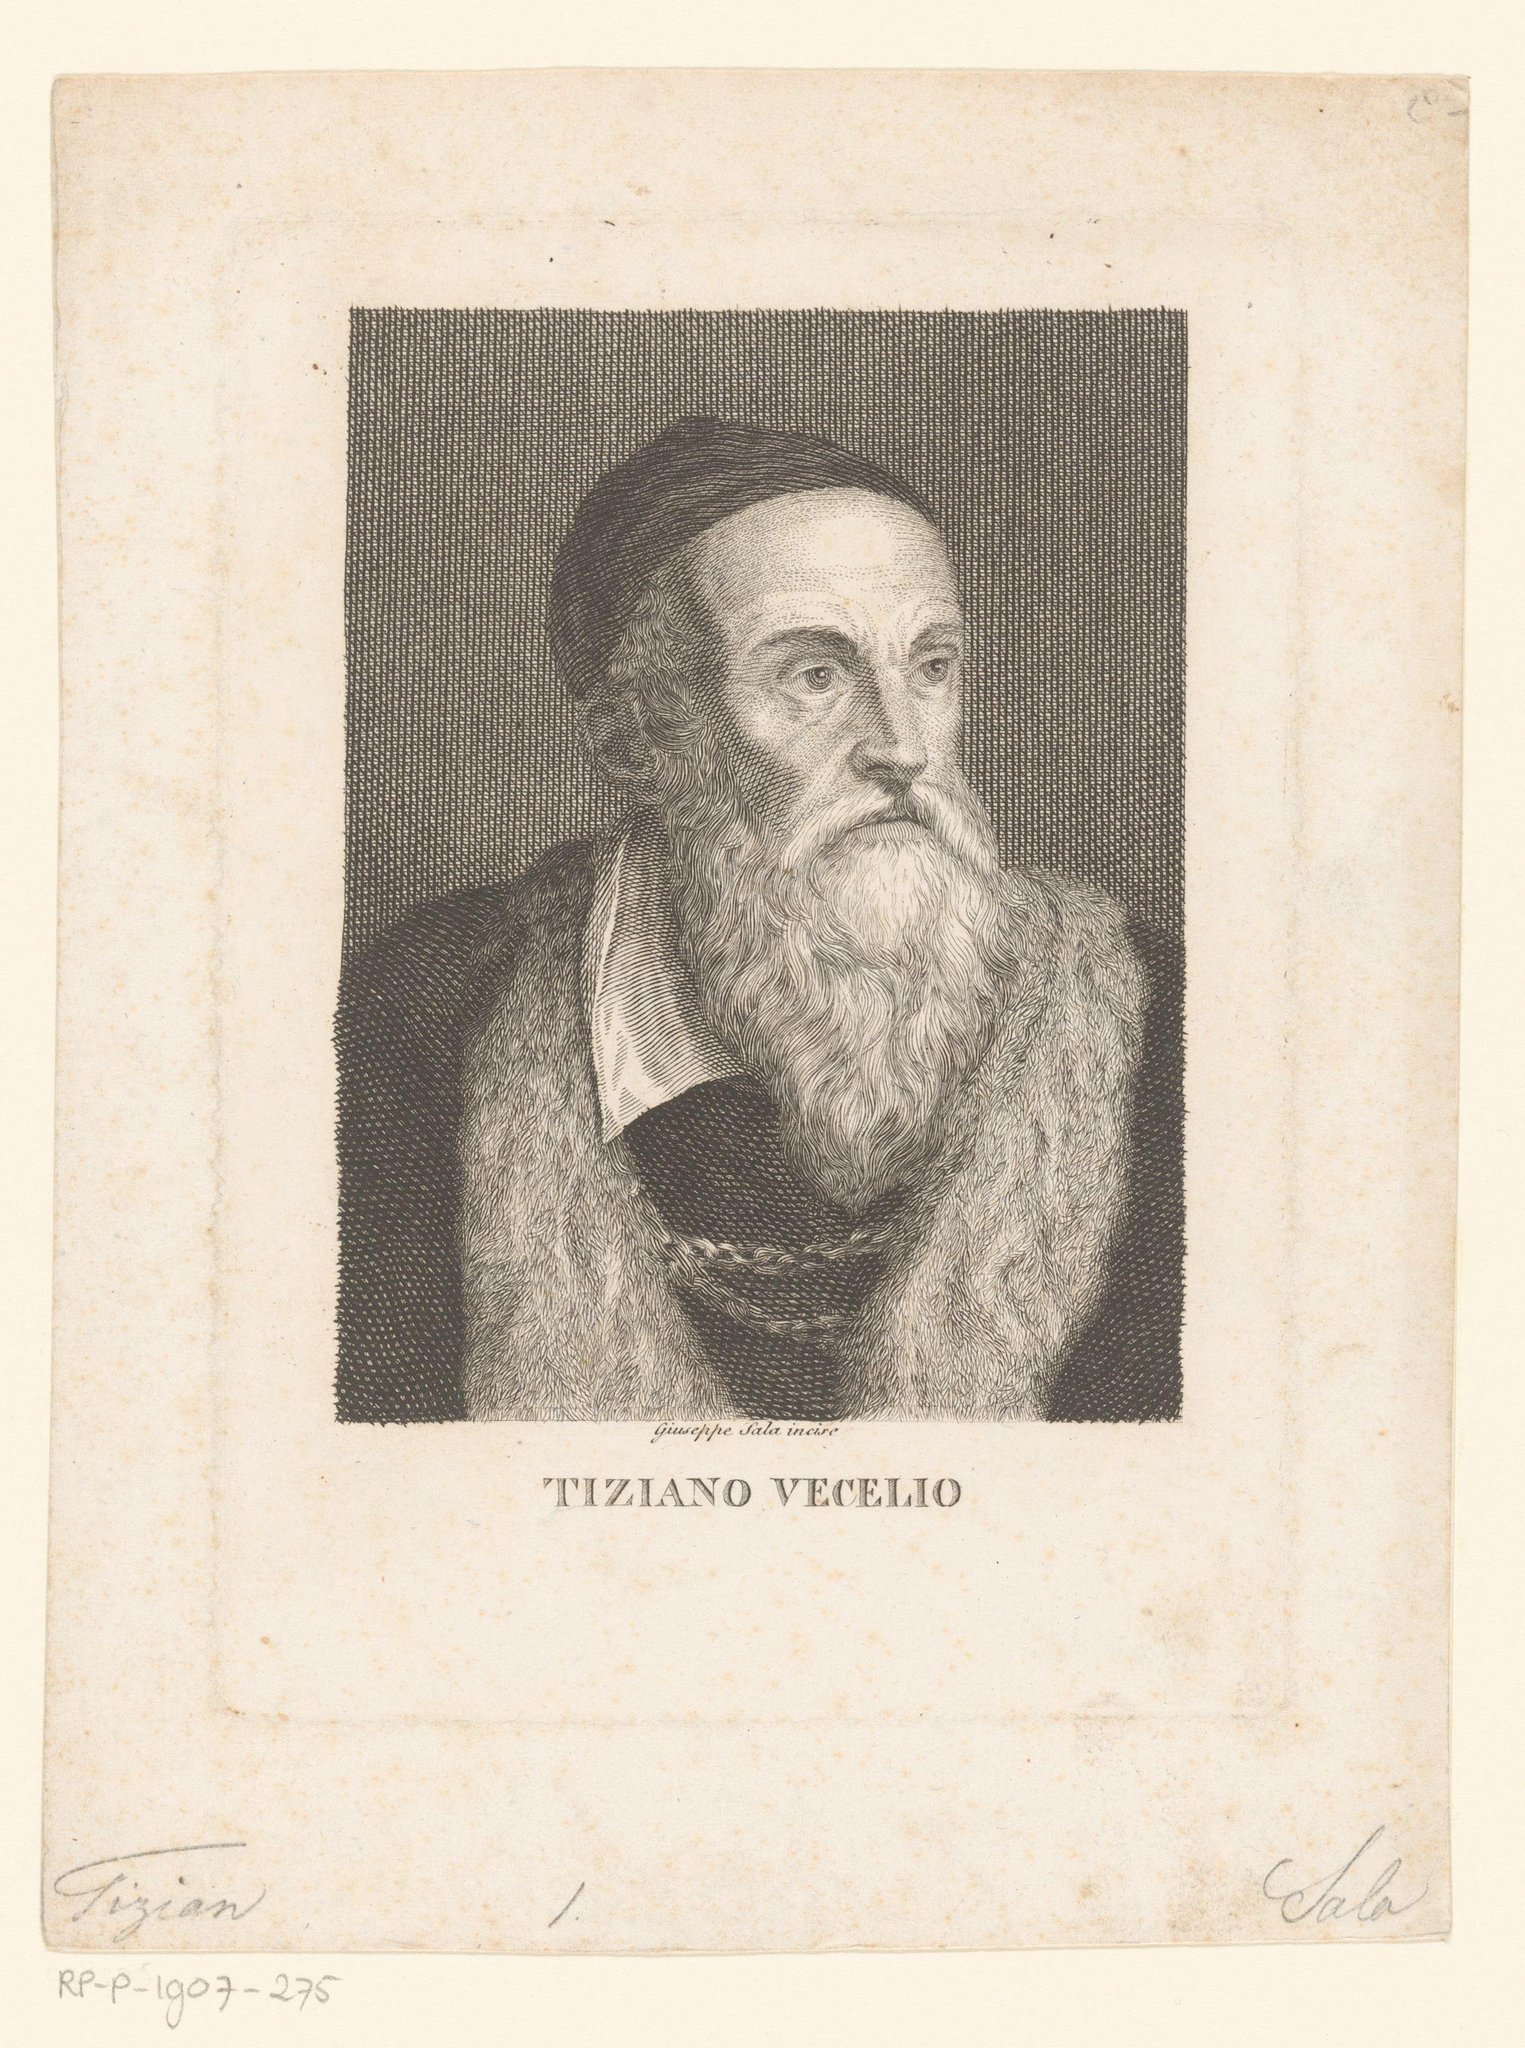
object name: print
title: Portret van schilder Titiaan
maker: giuseppe sala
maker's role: print maker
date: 1700-1799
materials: paper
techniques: engraving, etching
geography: italy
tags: venice, painter, draughtsman, titiaan, historical persons, portrait, self-portrait of artist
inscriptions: collector's mark: Lugt 2228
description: Naar geschilderd zelfportret van Titiaan in de Staatliche Museen Preussischer Kulturbesitz, Gemäldegalerie te Berlijn.